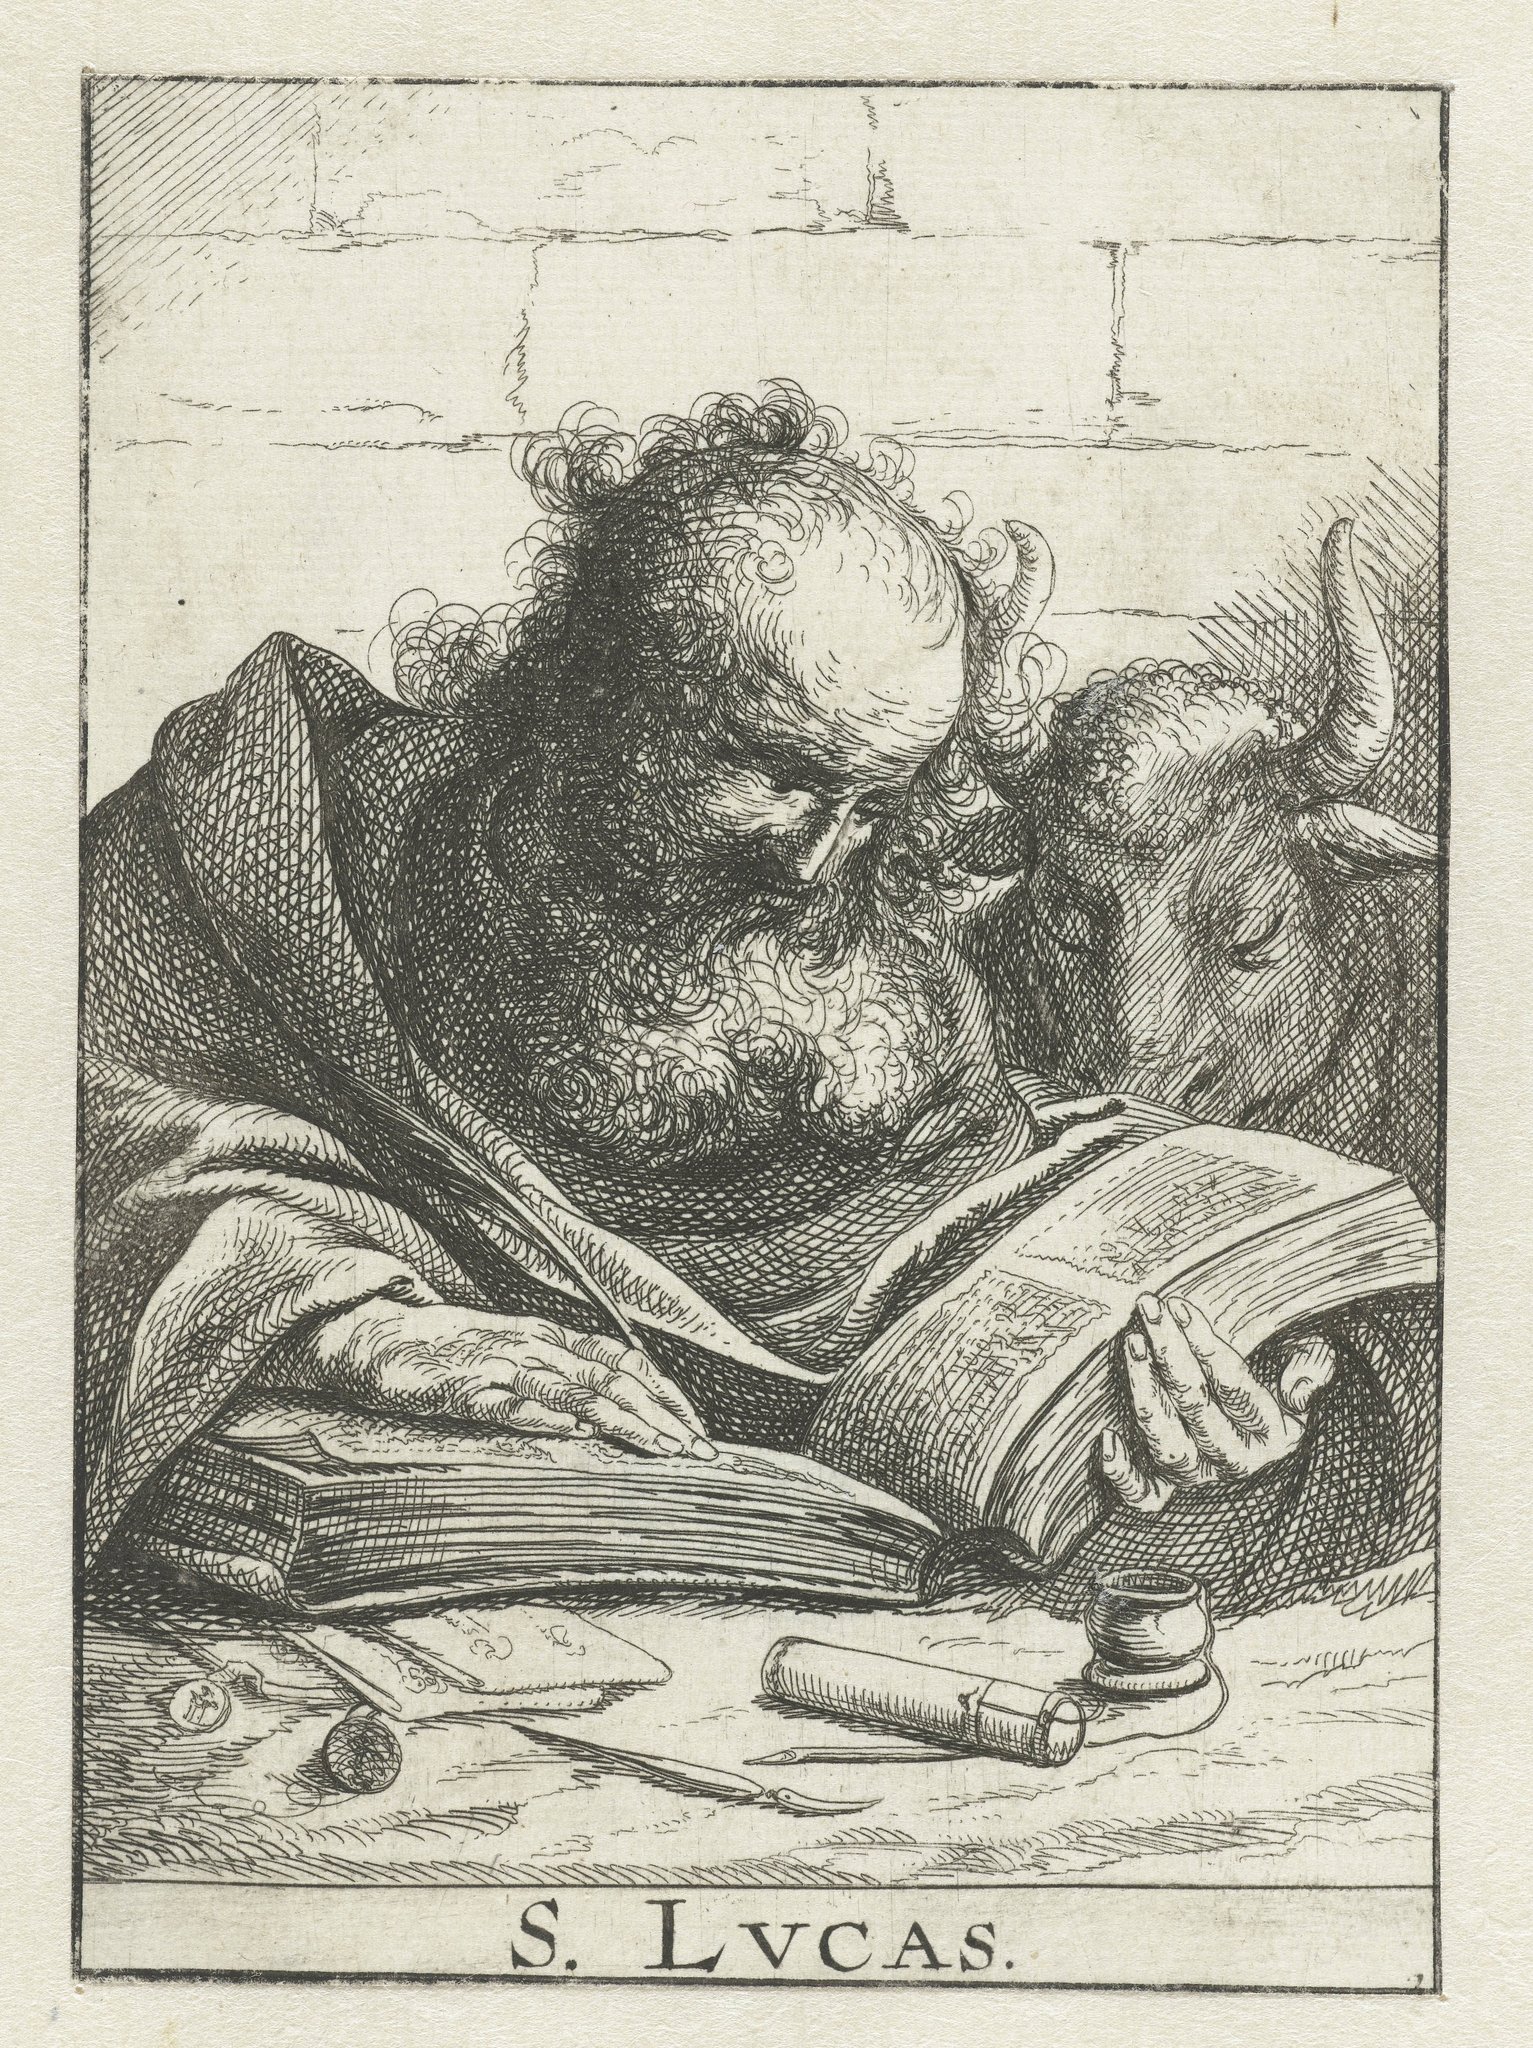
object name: print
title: De evangelist Lucas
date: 1625-1674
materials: paper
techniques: engraving, etching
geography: antwerp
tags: luke the evangelist; possible attributes: book, (winged) ox, portrait of the virgin, surgical instruments, painter's utensils, scroll, ox (possibly with book) ~ symbol of st. luke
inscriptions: collector's mark: Lugt 2228a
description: De evangelist Lukas met zijn attribuut de os